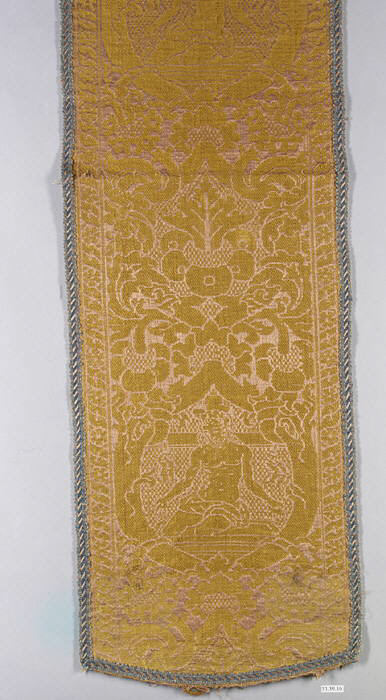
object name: orphrey fragment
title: Orphrey woven with figurative repeat design of Christ as Man of Sorrows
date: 1401-1600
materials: linen, silk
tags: men